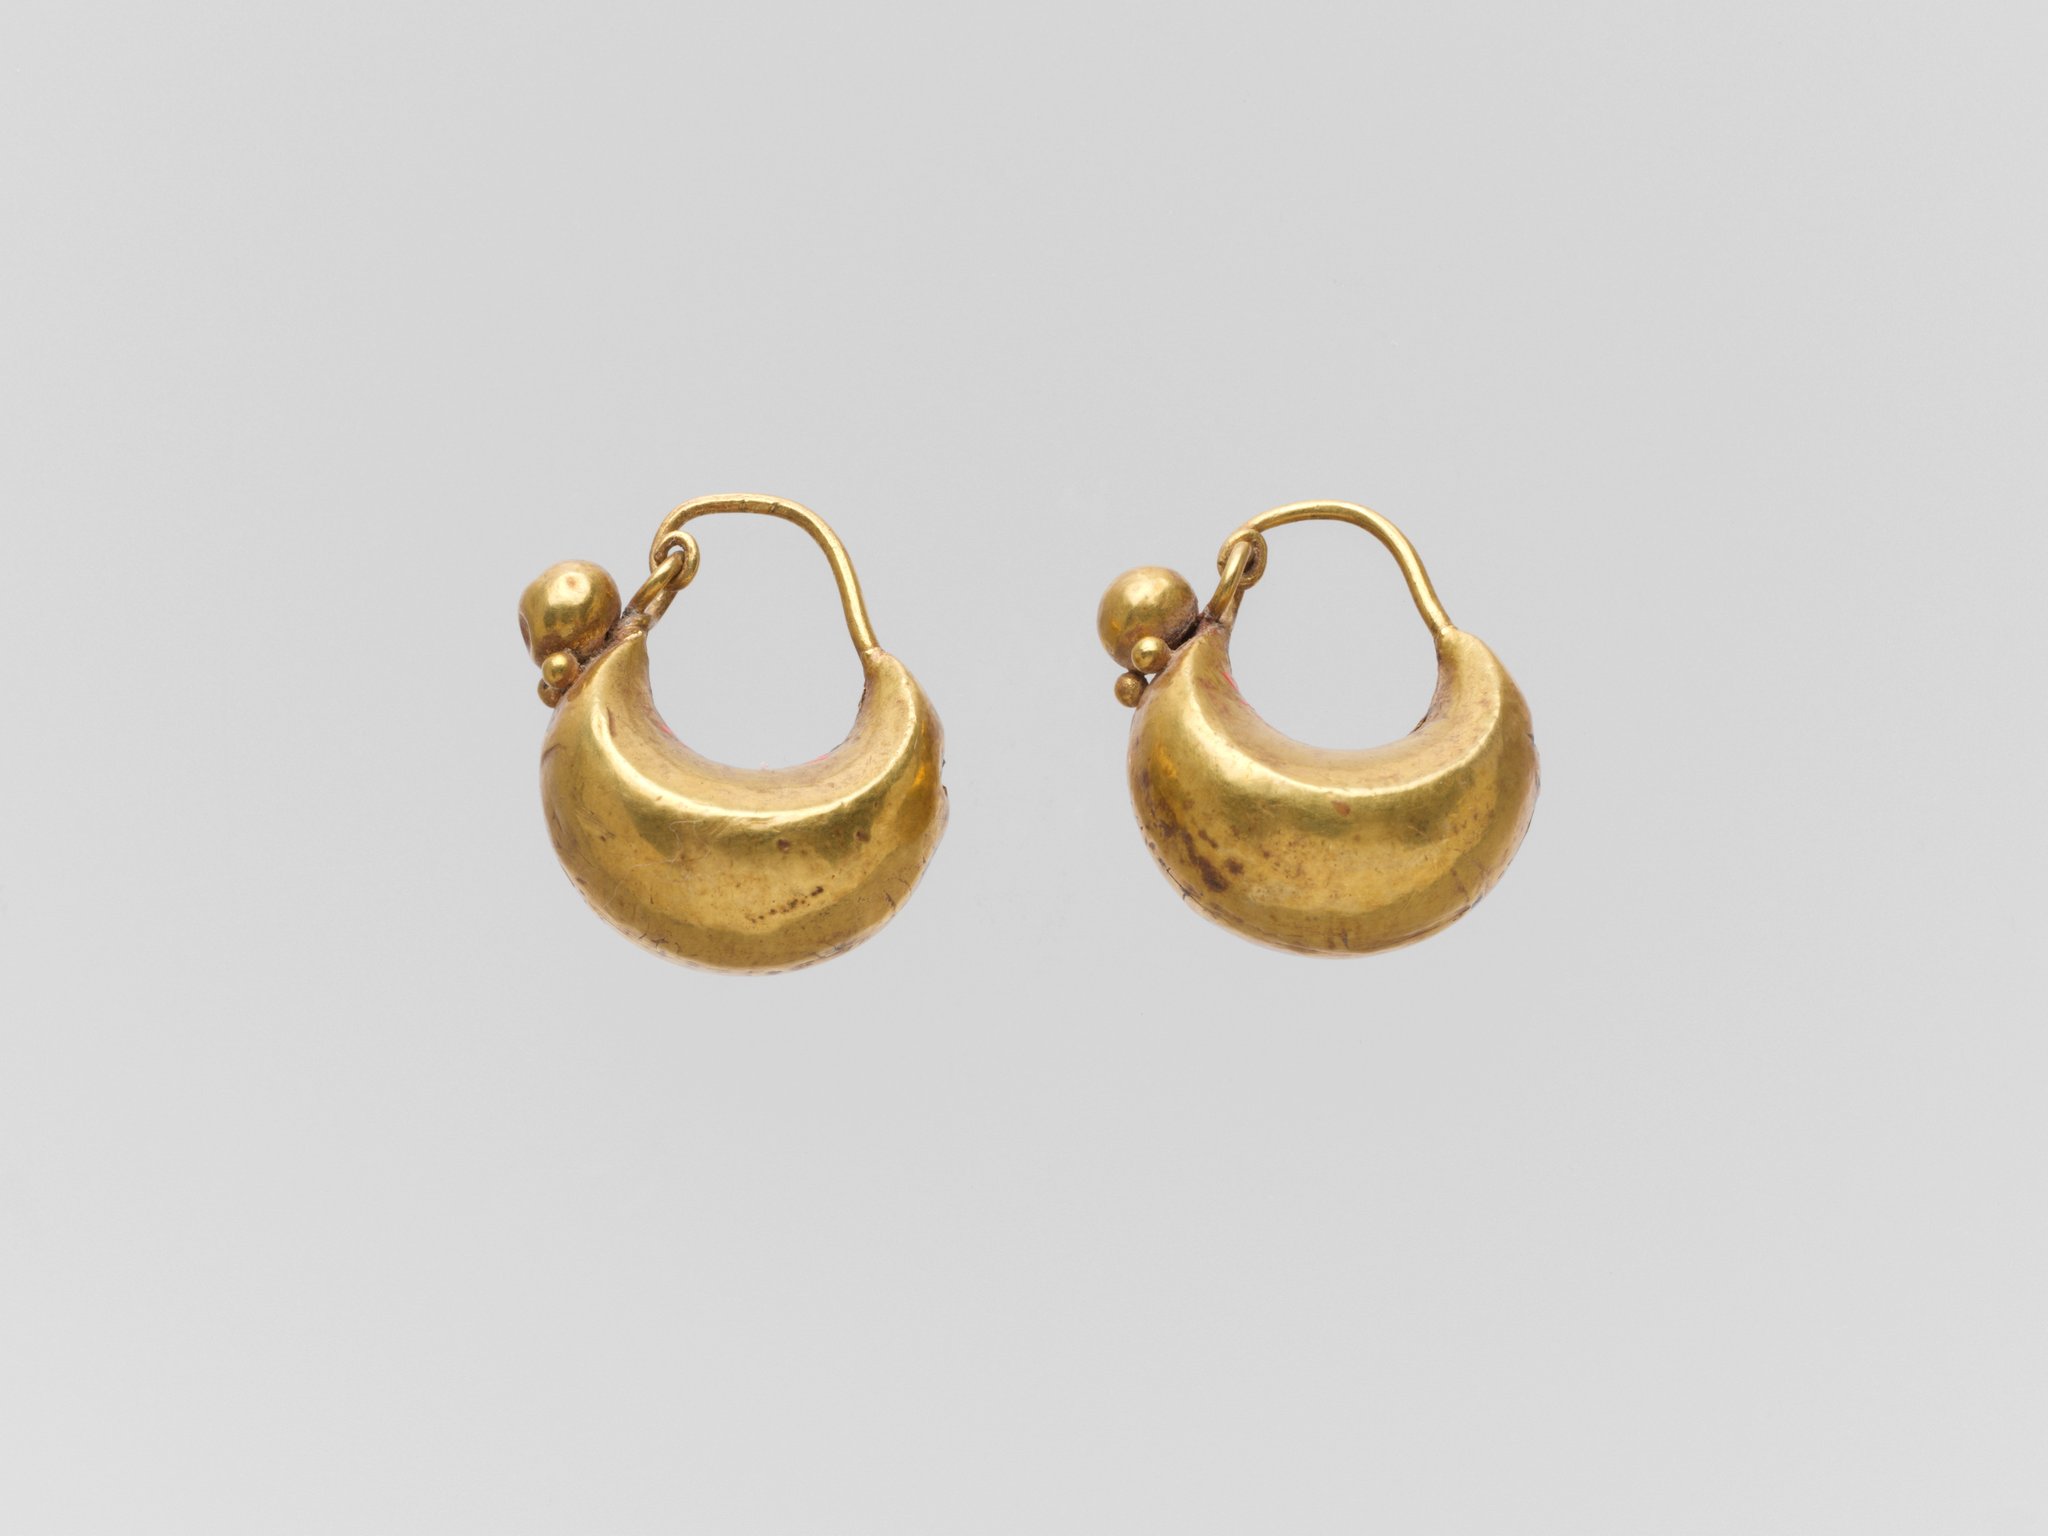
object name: pair of earring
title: Pair of gold boat-shaped earrings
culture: roman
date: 1-200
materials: gold